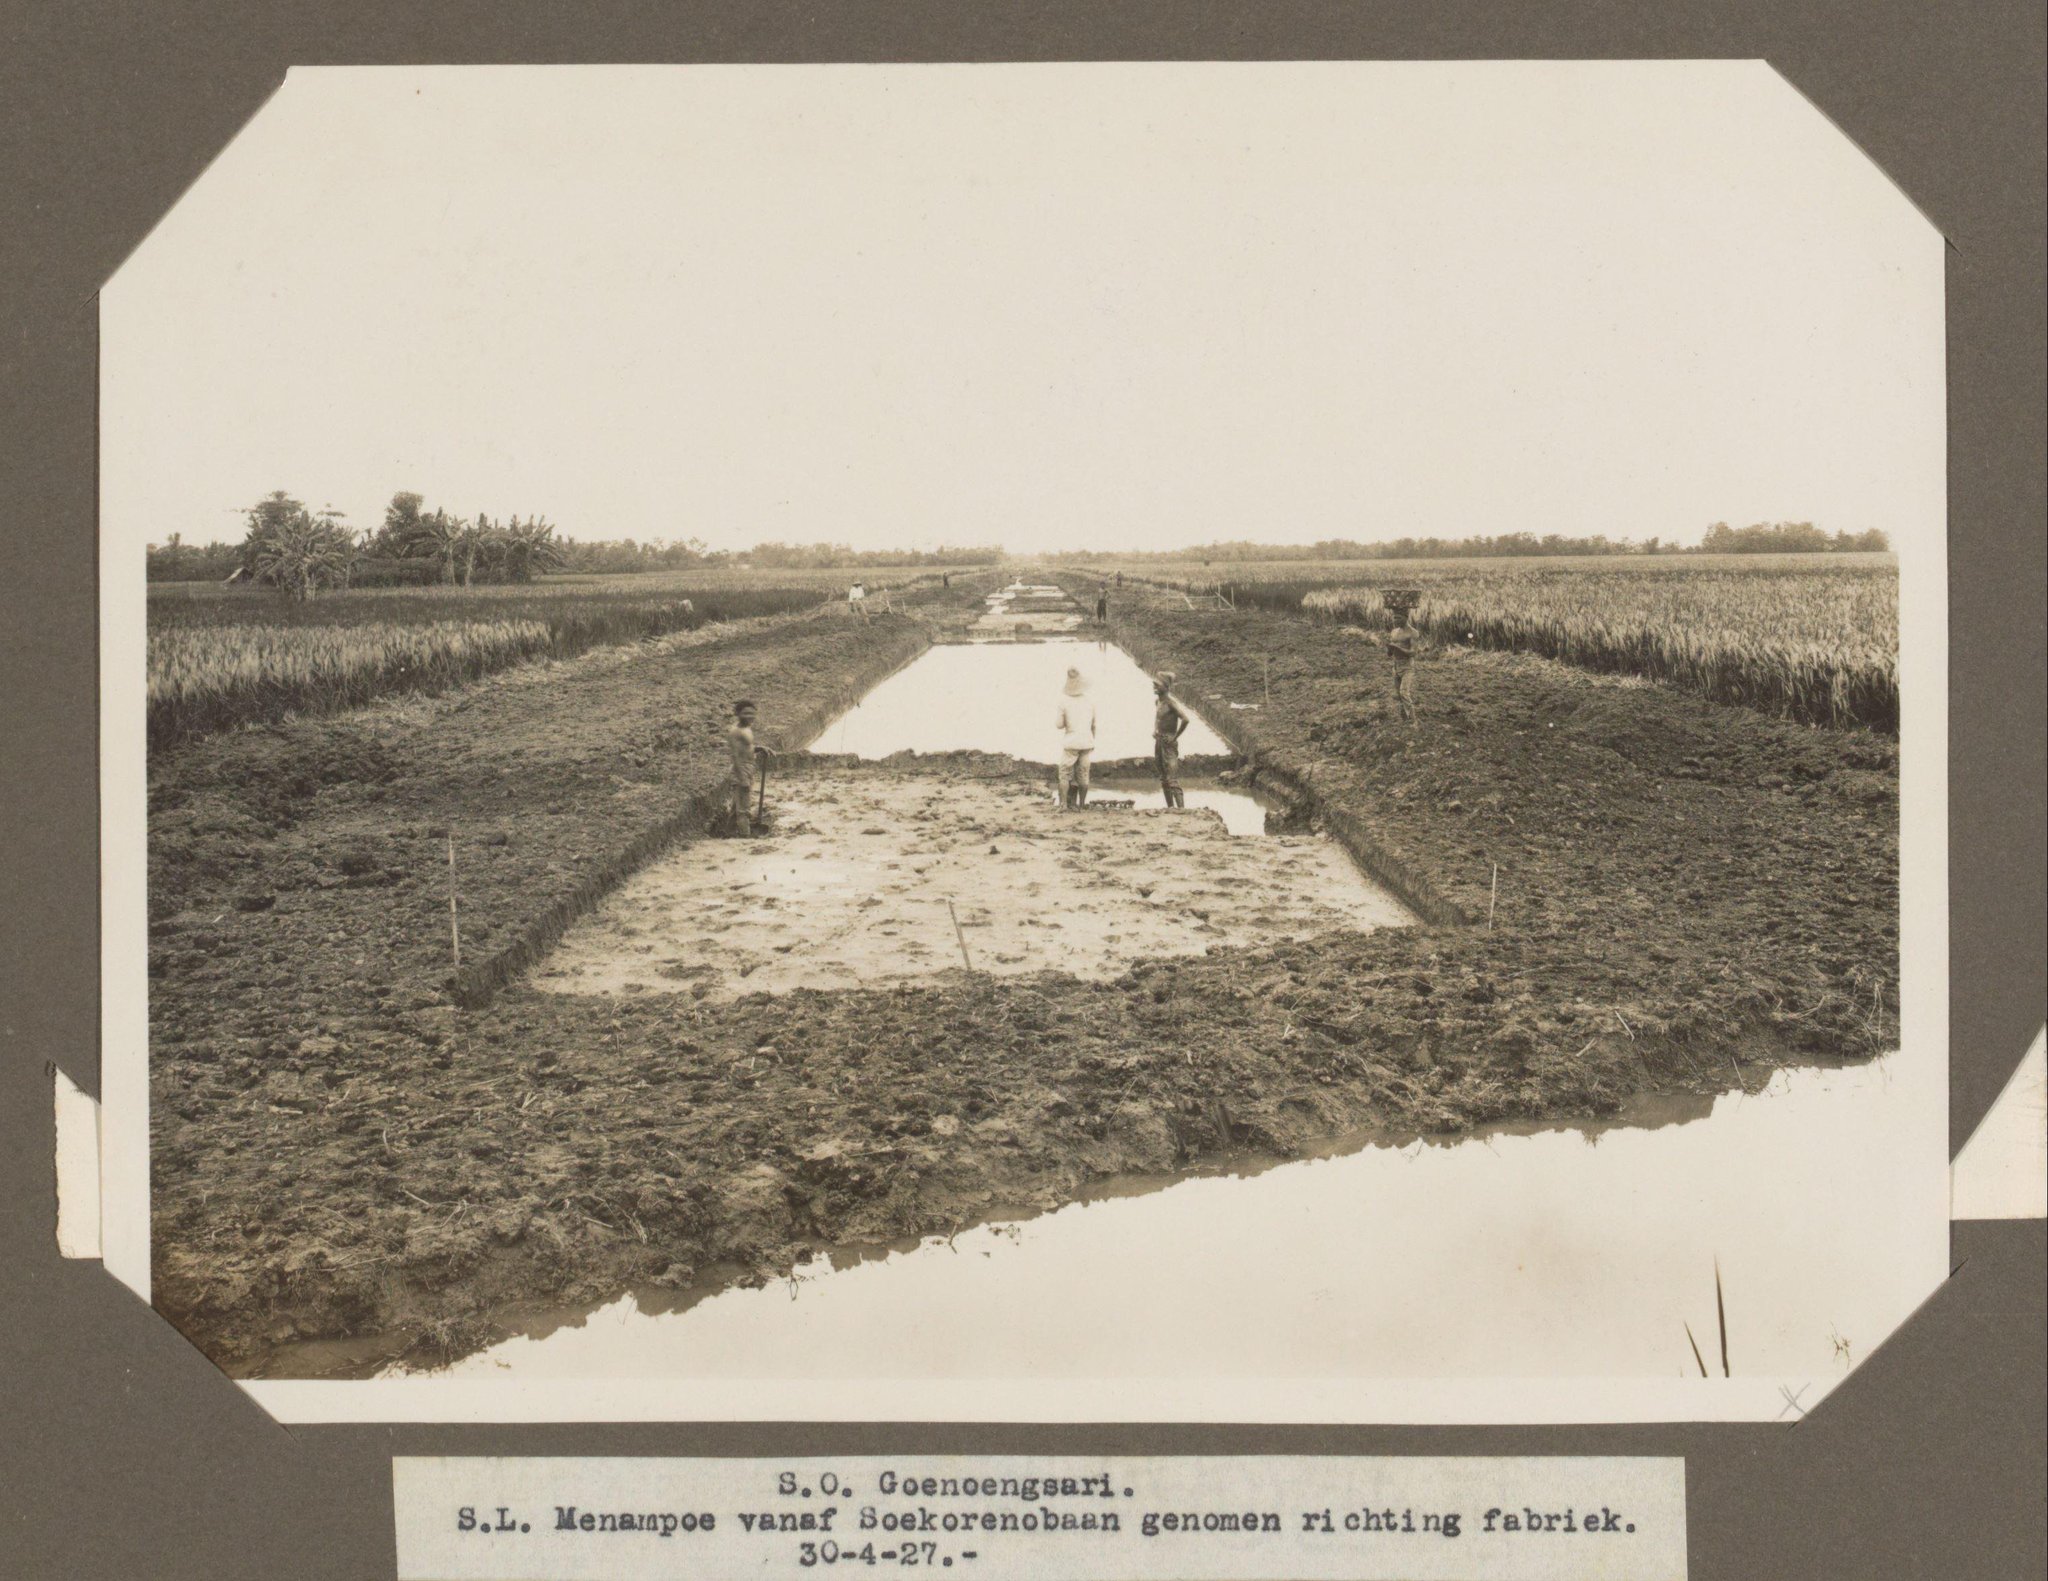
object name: photograph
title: S.O. Goenoengsari. S.L. Menampoe vanaf Soekorenobaan genomen richting fabriek. 30-4-27.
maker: Anonymous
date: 1904-1927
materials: photographic support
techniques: gelatin silver print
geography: east java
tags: colonial system, trade-company, making the overground structures (~ building activities), (non-fruit) products of plants or trees: sugarcane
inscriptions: inscription: ‘S.O. Goenoengsari. S.L. Menampoe vanaf Soekorenobaan genomen richting fabriek. 30-4-27.’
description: Werkzaamheden aan de aan- en afvoerkanalen op het fabrieksterrein, april 1927. Onderdeel van het fotoalbum met foto's van de opbouw van de suikerfabriek te Goenoengsari op Oost-Java door de Handels Vereniging Amsterdam 1926-1927.